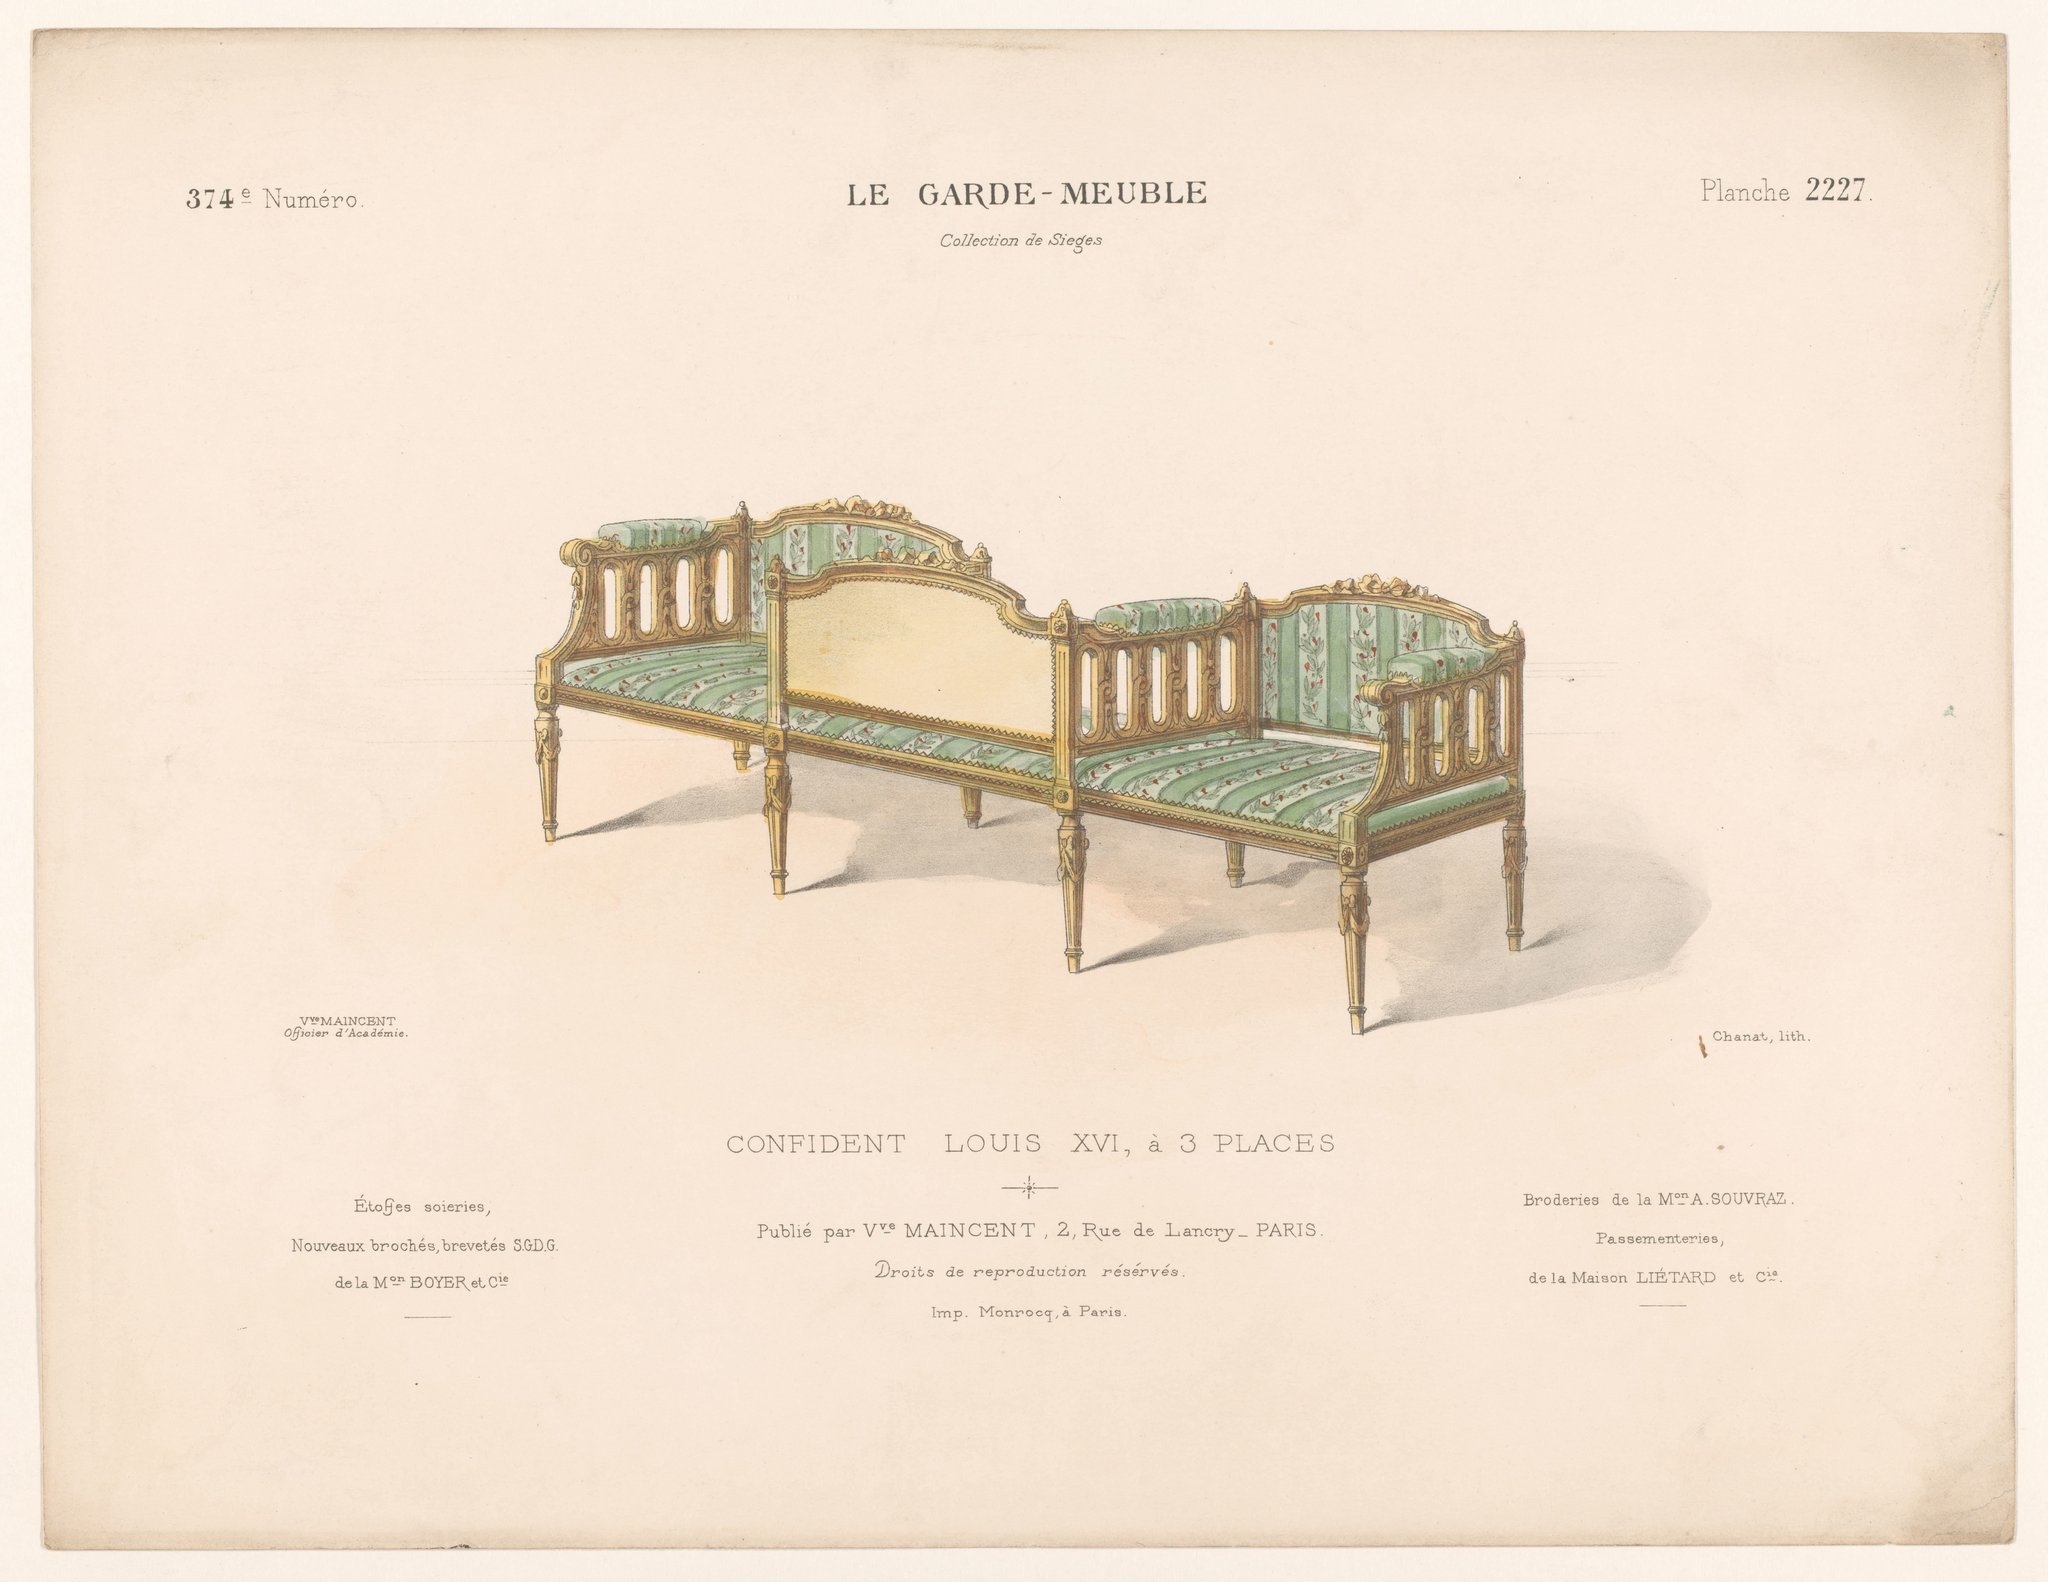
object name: print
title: Confident Louis XVI, à 3 places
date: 1895-1935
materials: paper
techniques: hand coloring, lithograph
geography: paris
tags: seating furniture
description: Ieder Livraison in de serie Le Garde-Meuble bevat negen platen: drie 'sièges' (zitmeubels), drie 'meubles' (diverse meubels zoals tafels en kasten) en drie 'tentures' (gordijnen en draperieën).